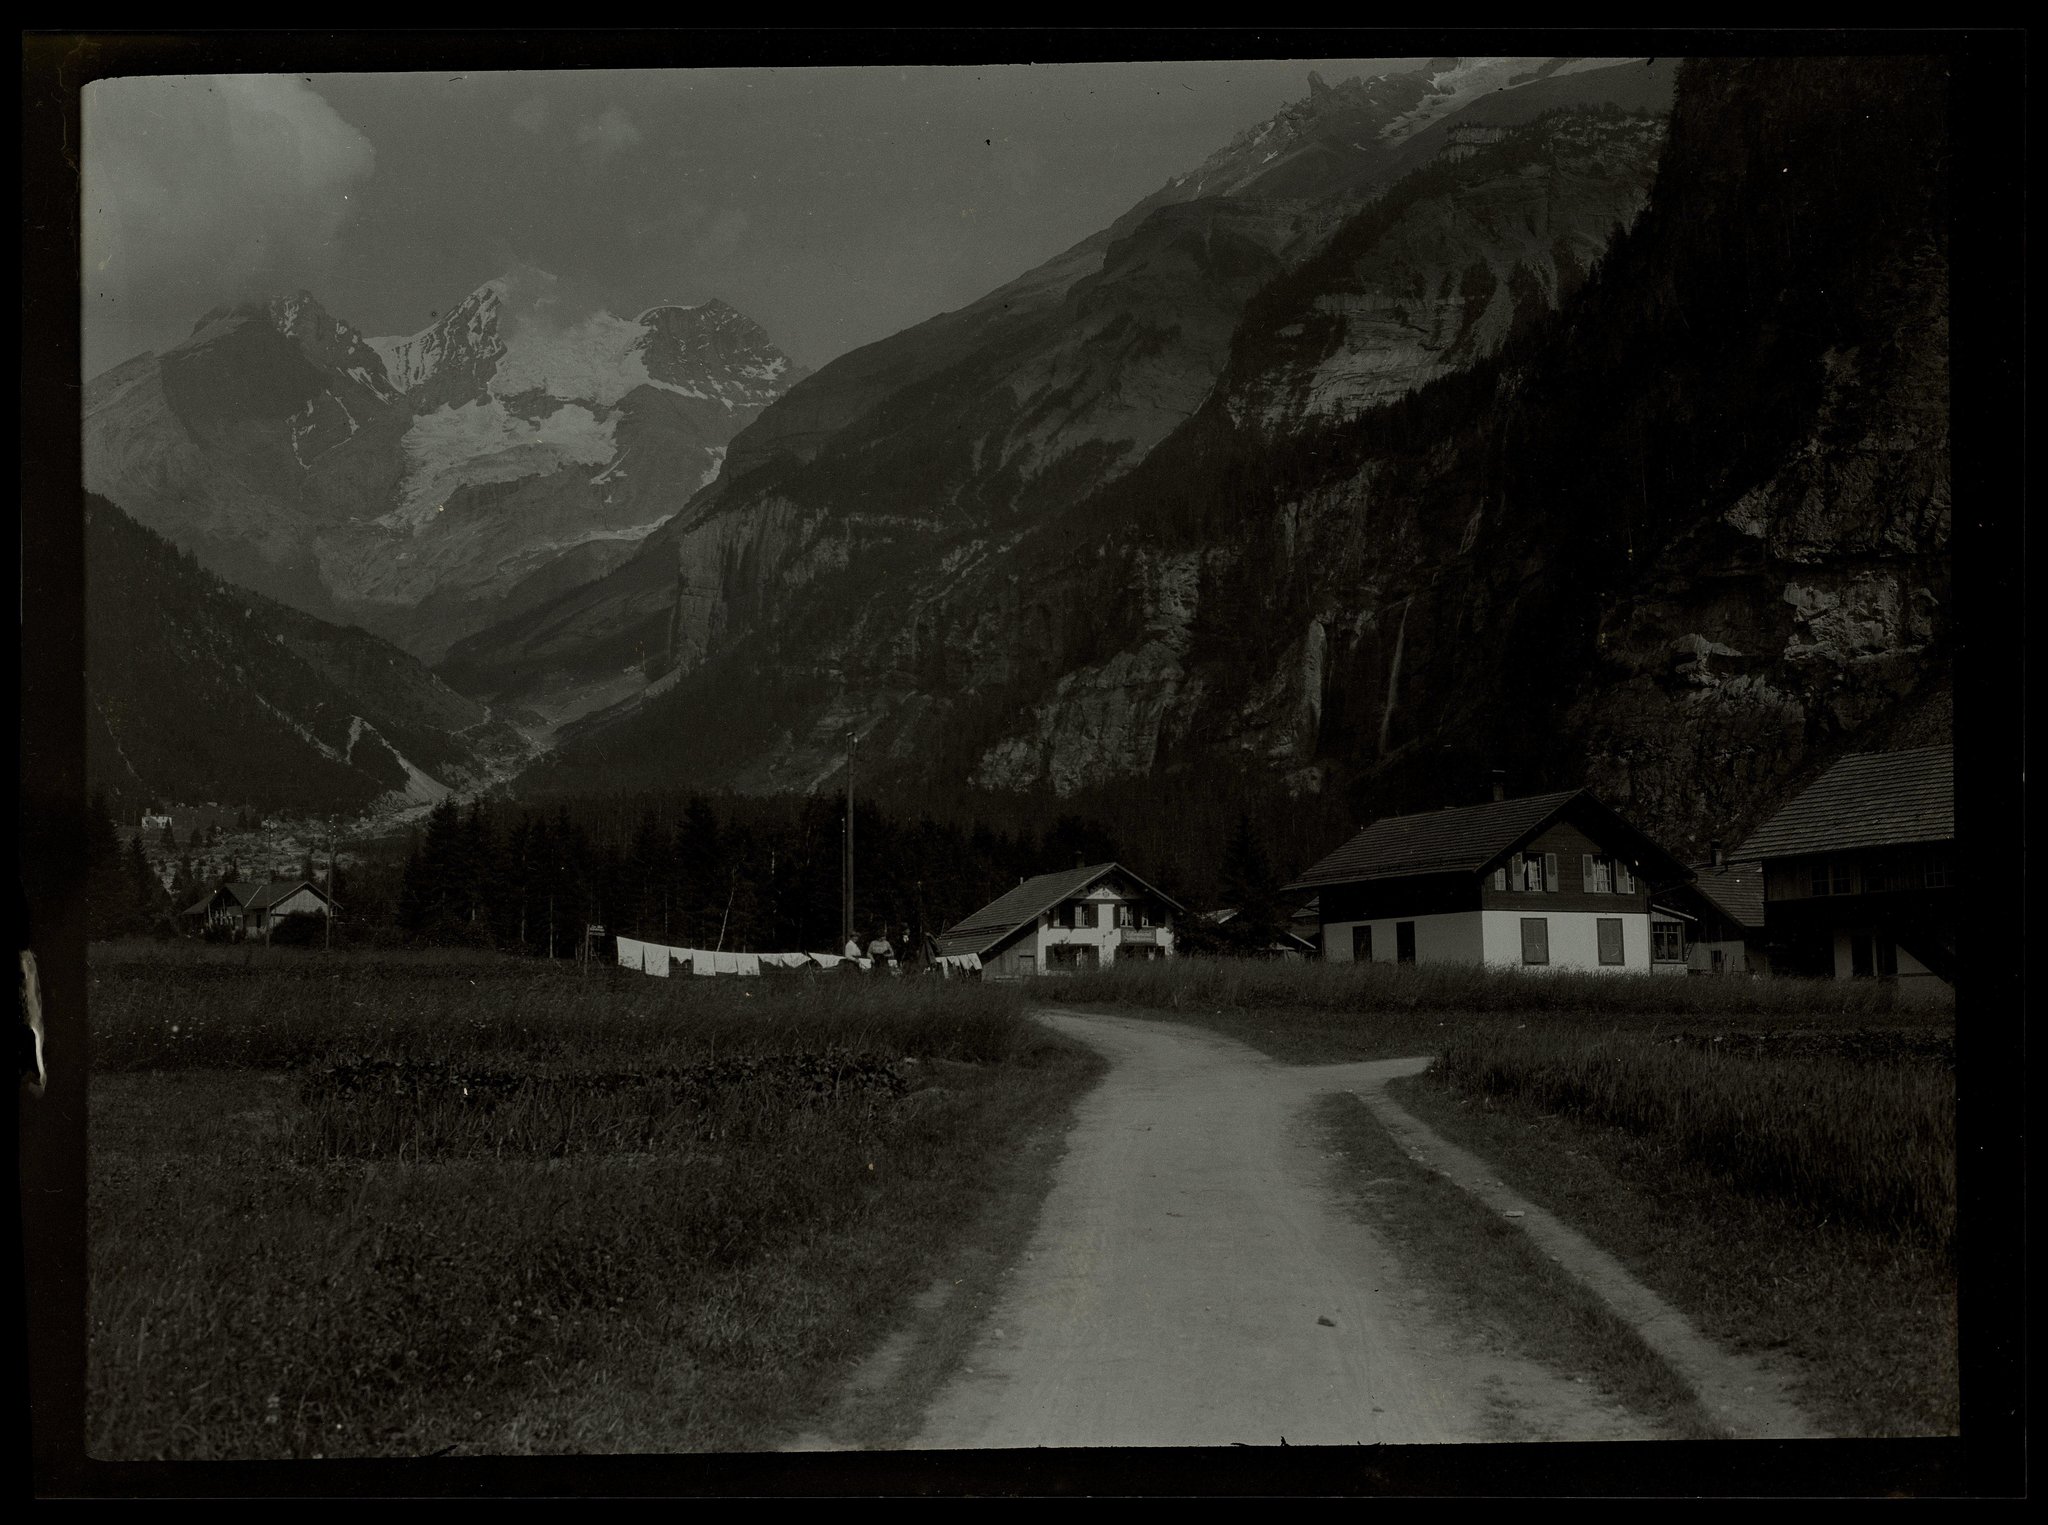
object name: photograph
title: Filmnegatief met opname van Basel, Thun, Kandersteg of Gemmi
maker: Anonymous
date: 1921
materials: film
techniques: gelatin silver negative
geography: switzerland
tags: switzerland